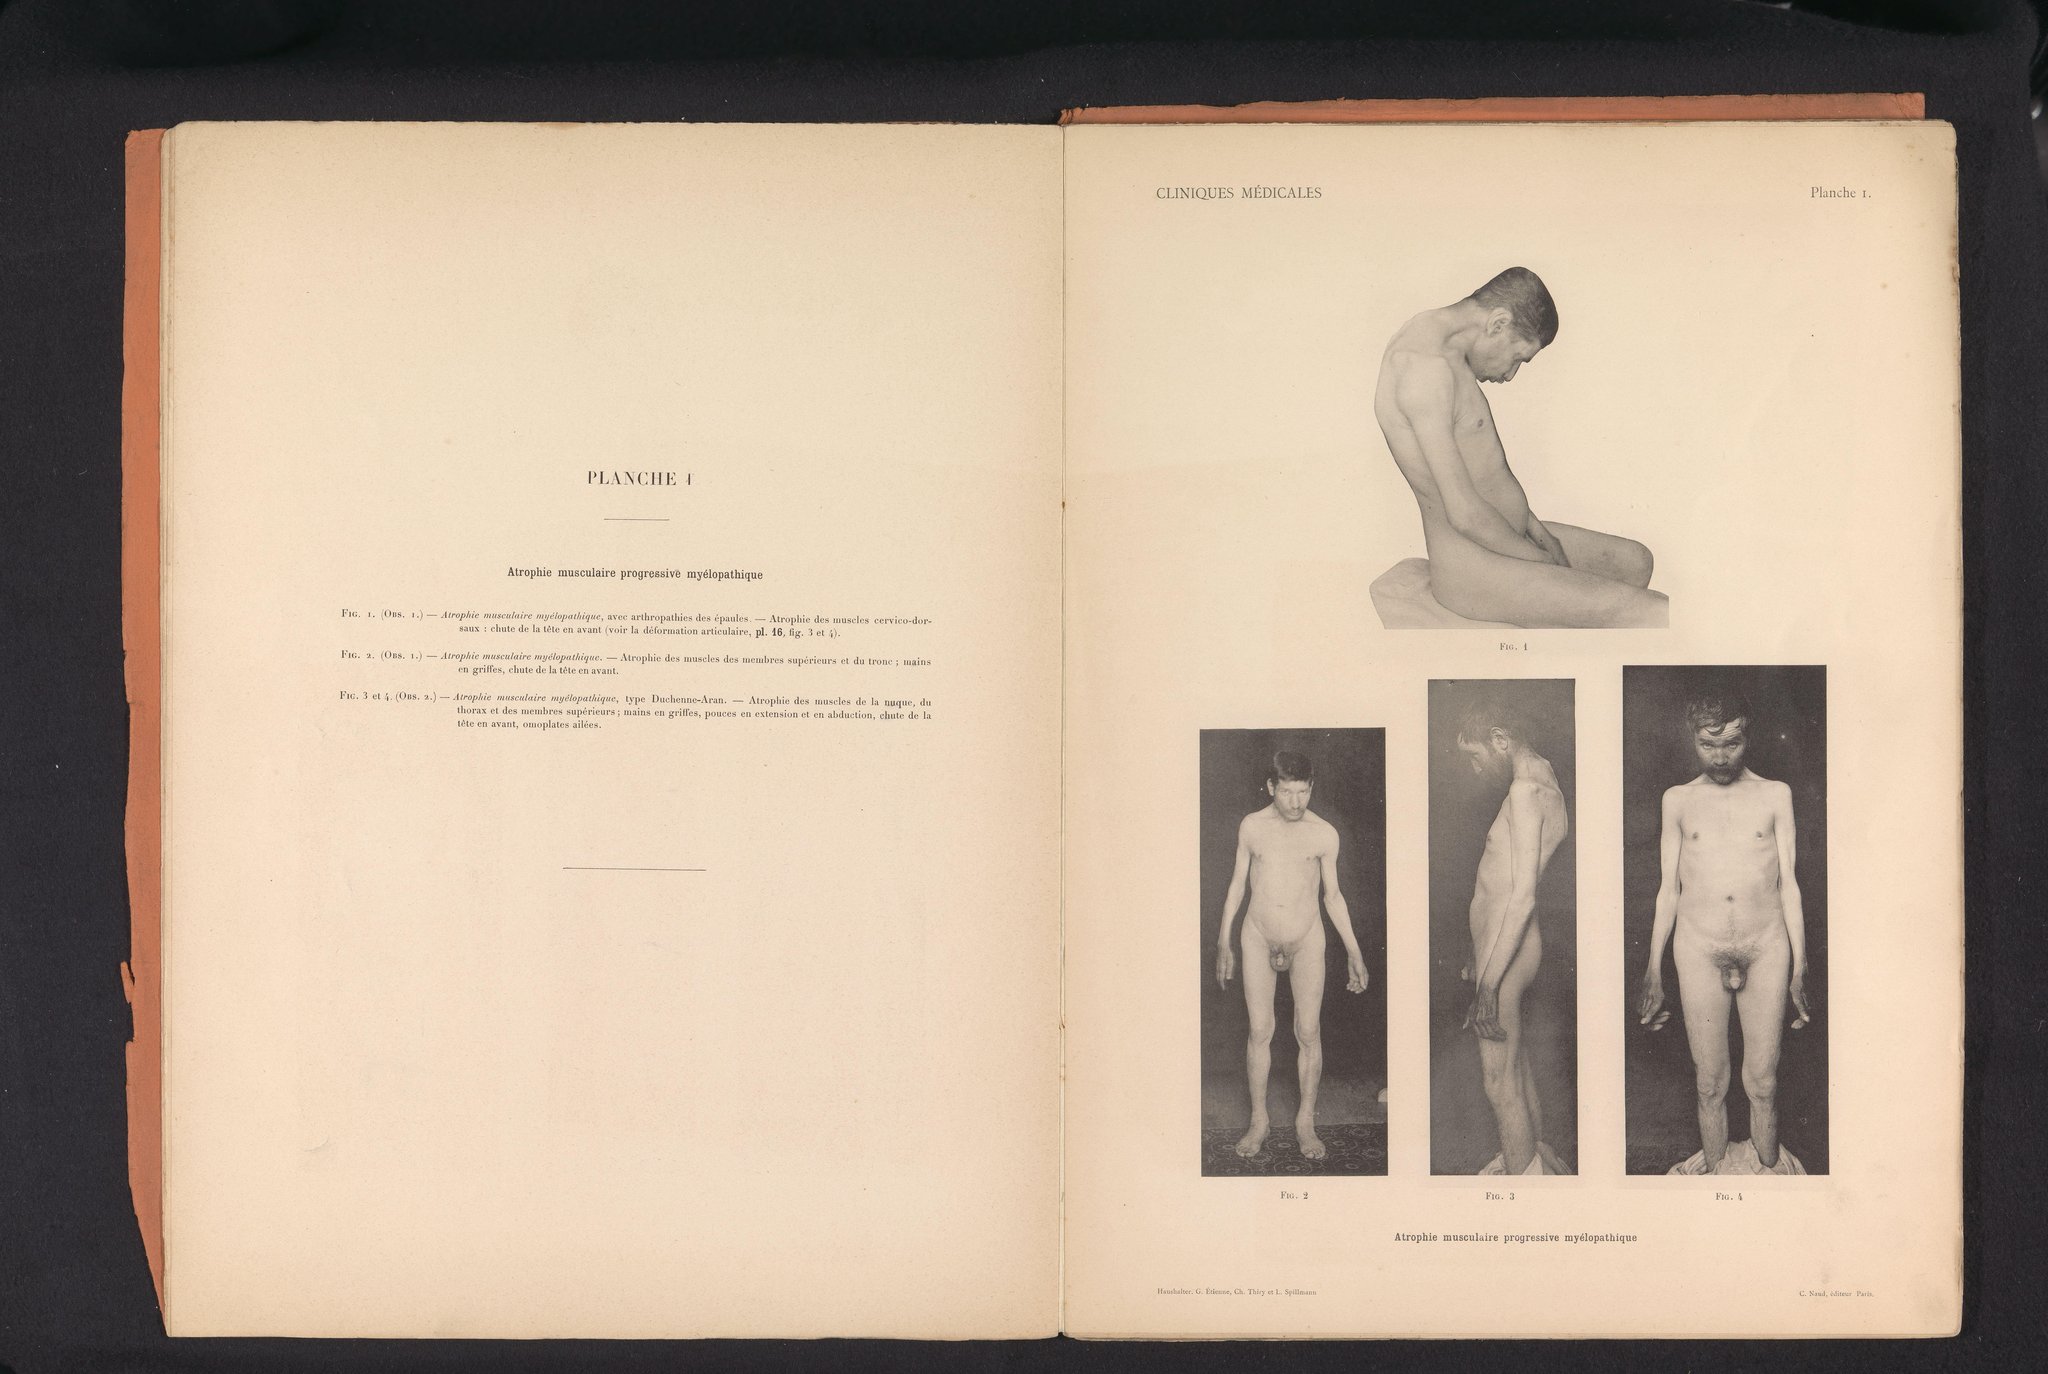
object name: page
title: Atrophie musculaire progressive myélopathique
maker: Anonymous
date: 1896-1901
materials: paper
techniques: photograph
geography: nancy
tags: crooked, bent person, man (showing himself) undressed, quasi-nude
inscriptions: number: ‘Fig. 1 (...) Fig. 4’, number: ‘Planche 1.’